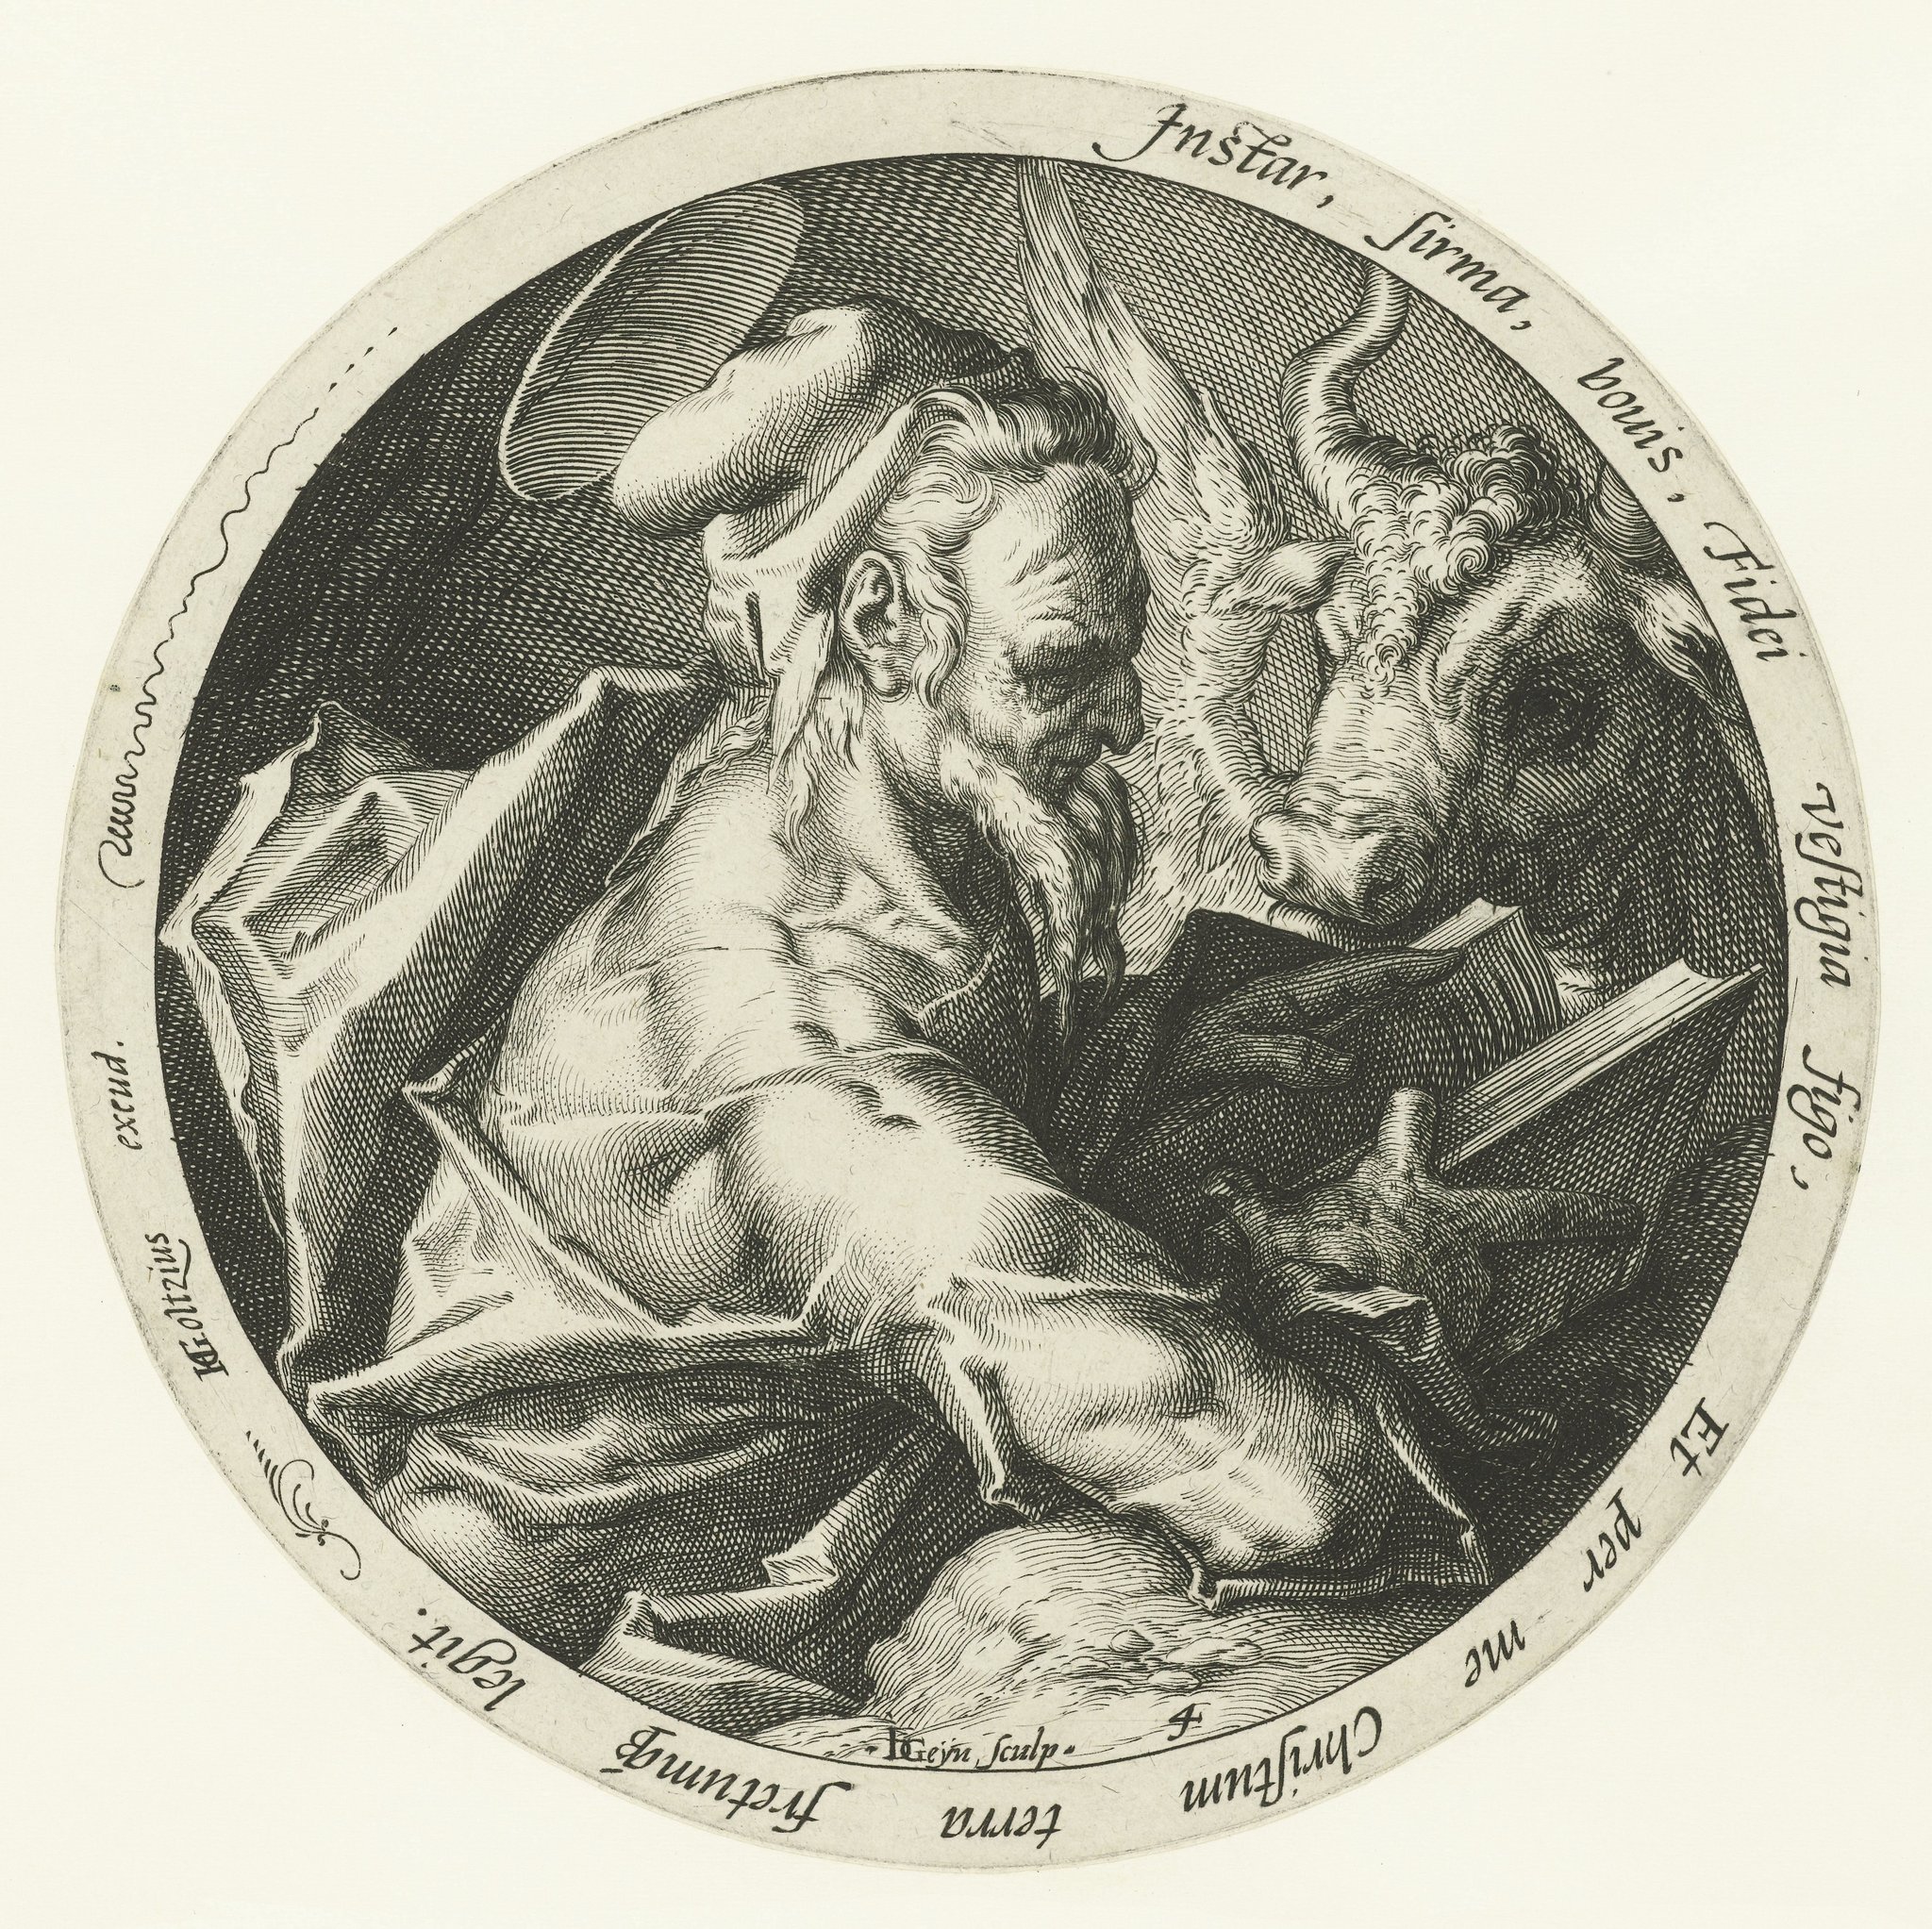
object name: print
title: Evangelist Lucas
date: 1588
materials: paper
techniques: engraving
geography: netherlands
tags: luke the evangelist; possible attributes: book, (winged) ox, portrait of the virgin, surgical instruments, painter's utensils, scroll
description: Lucas de evangelist, ten halven lijve, lezend in een boek. Aan zijn linkerzijde staat een gevleugeld rund. Om de voorstelling een Latijnse tekst. Deze prent is onderdeel van een serie van vier ronde voorstellingen van de evangelisten, elk omgeven door een witte band waarin een regel Latijn. Deze derde prent is abusievelijk '4' genummerd onderin.